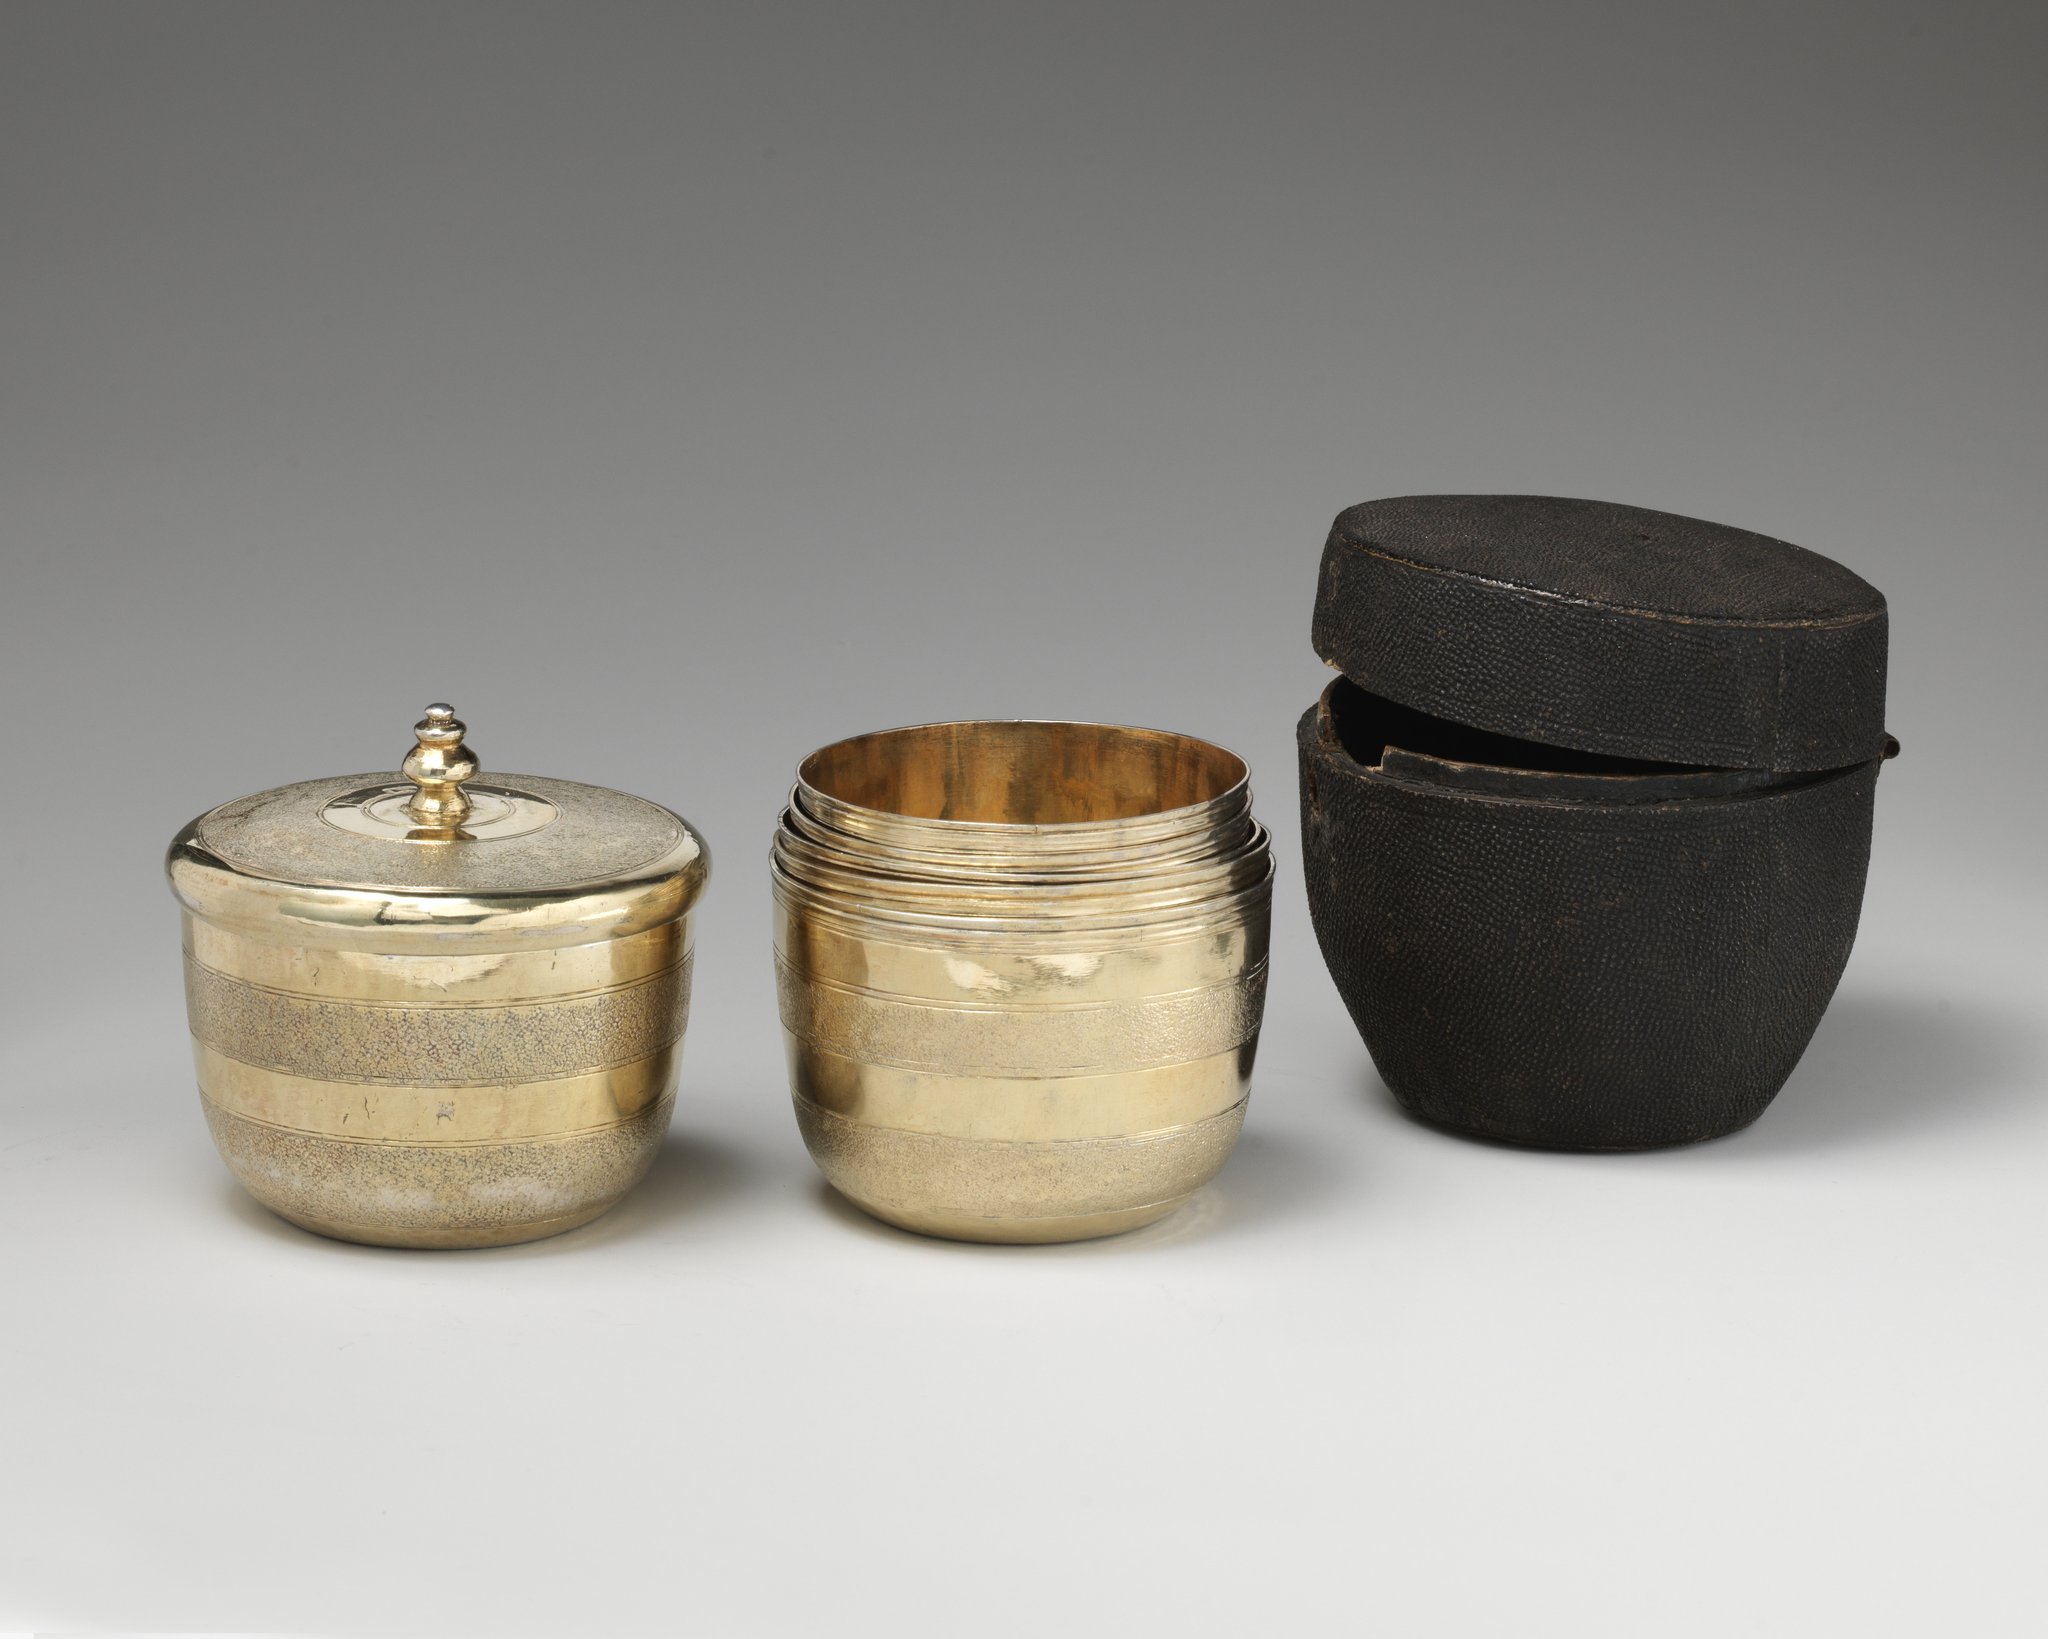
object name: nesting beaker with case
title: Set of six nesting beakers with case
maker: p. h., london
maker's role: maker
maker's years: 1676-1696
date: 1688-1689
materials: gilt silver